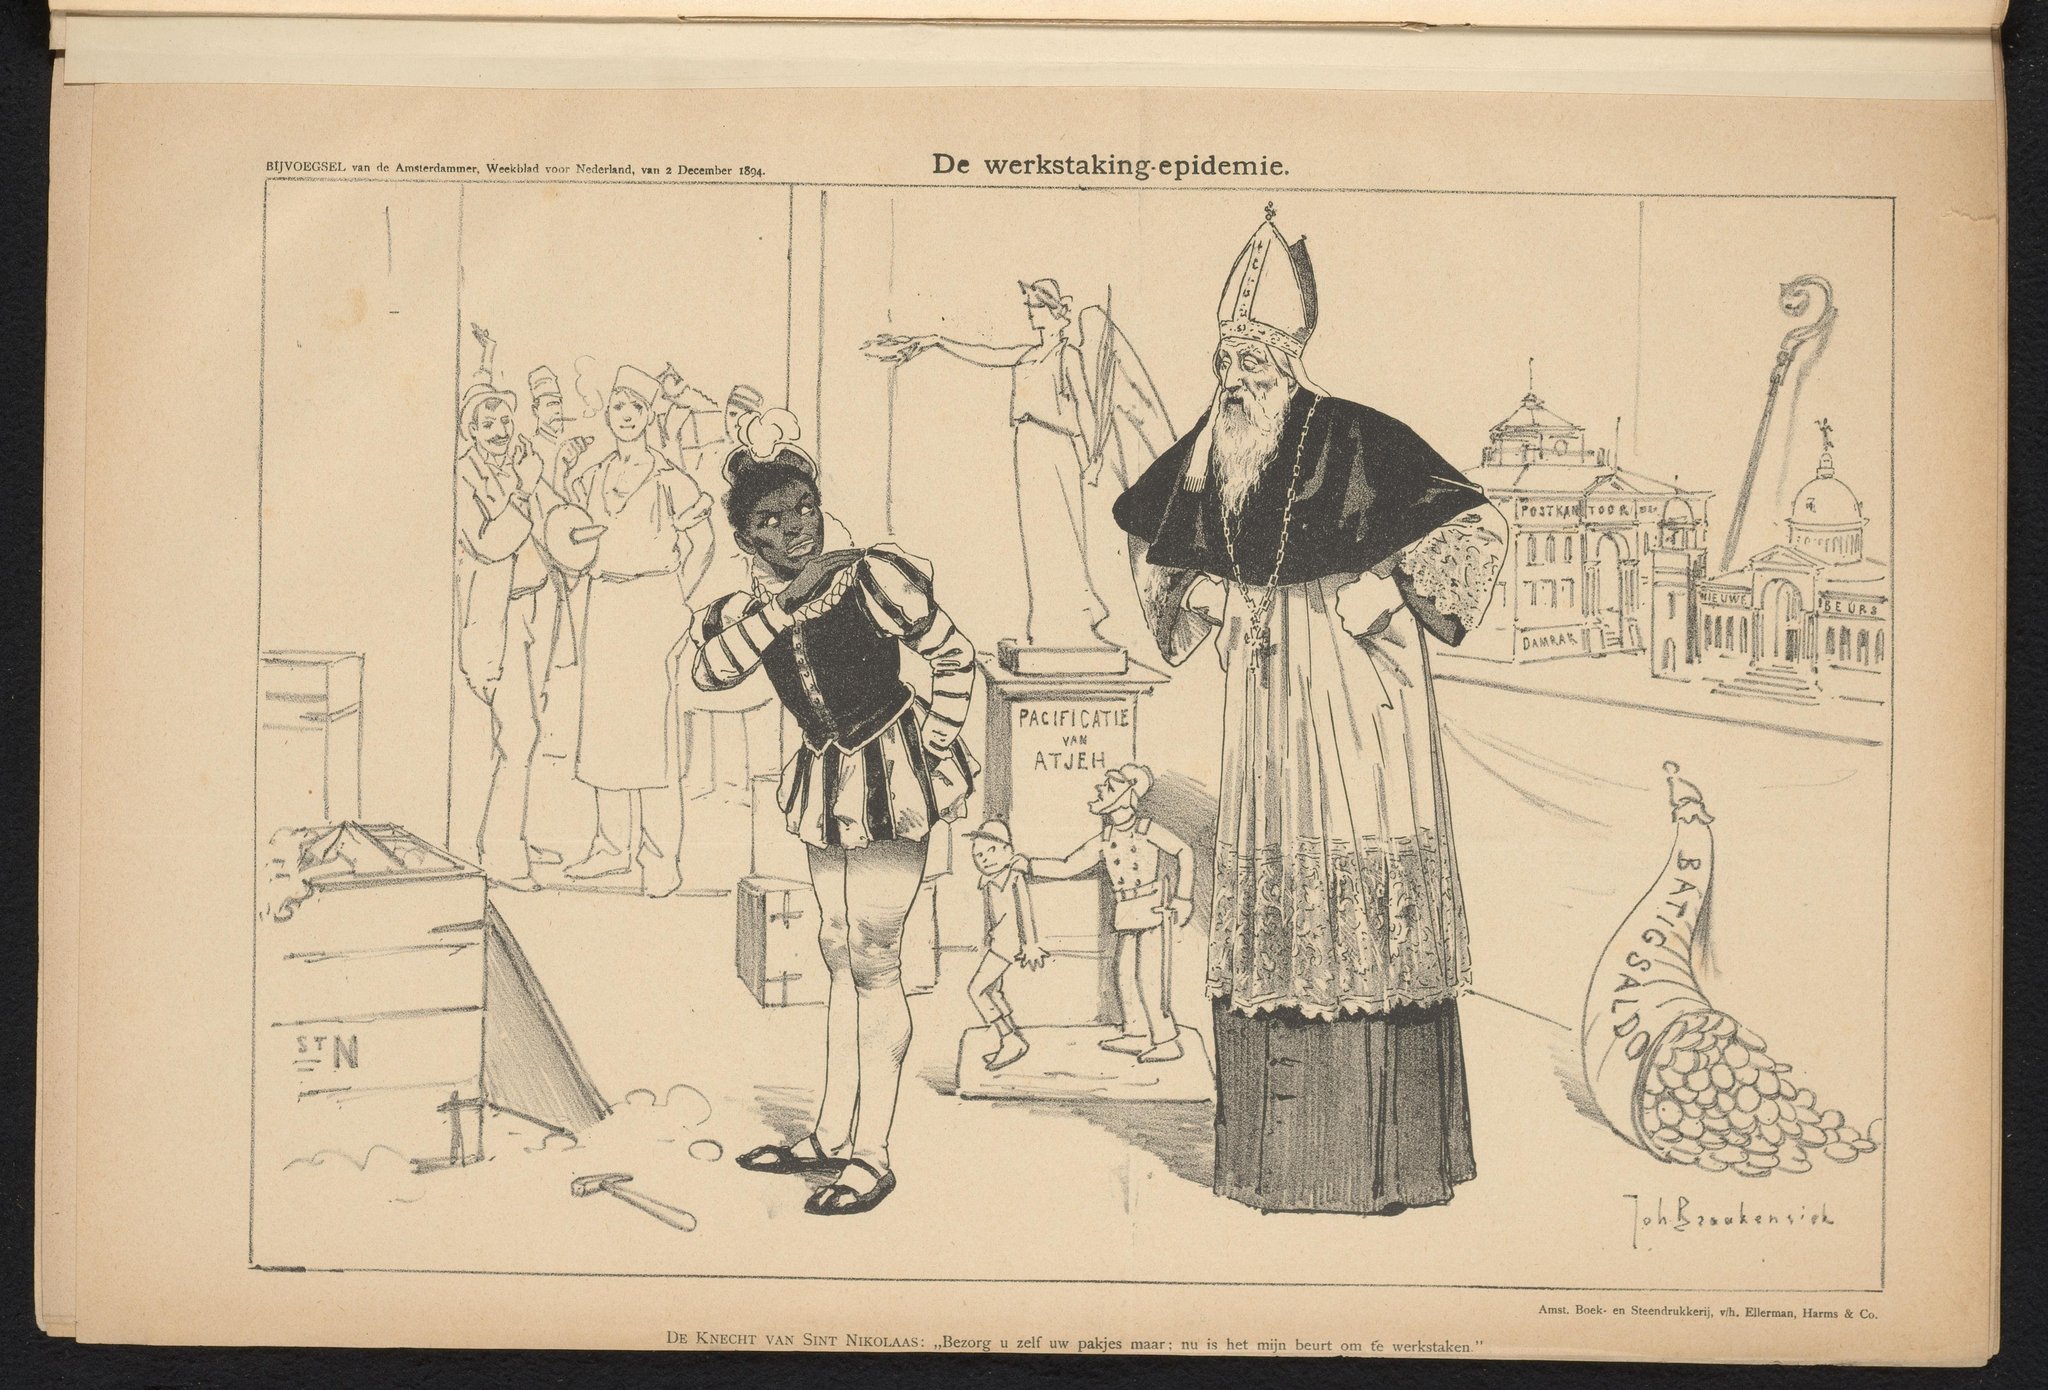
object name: cartoon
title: De werkstaking-epidemie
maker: johan braakensiek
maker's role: draughtsman, print maker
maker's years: 1858-1940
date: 1894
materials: paper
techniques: lithograph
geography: amsterdam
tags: 'cornucopia', horn of plenty, festivities on st. nicholas (eve) (december 5), welfare, prosperity; 'felicità publica', 'prosperità della vita', 'salute' (ripa), strike (political demonstration), political caricatures and satires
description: Na andere sectoren gaat Zwarte Piet ook staken en vertelt Sint Nicolaas dat hij zelf maar de pakjes moet bezorgen. Op de achtergrond verwijzingen naar positieve ontwikkelingen in Nederland: nieuwe gebouwen in Amsterdam, de pacificatie van Atjeh, een straatjongen wordt door een politieagent in de kraag gevat en een hoorn van overvloed vol geldstukken.